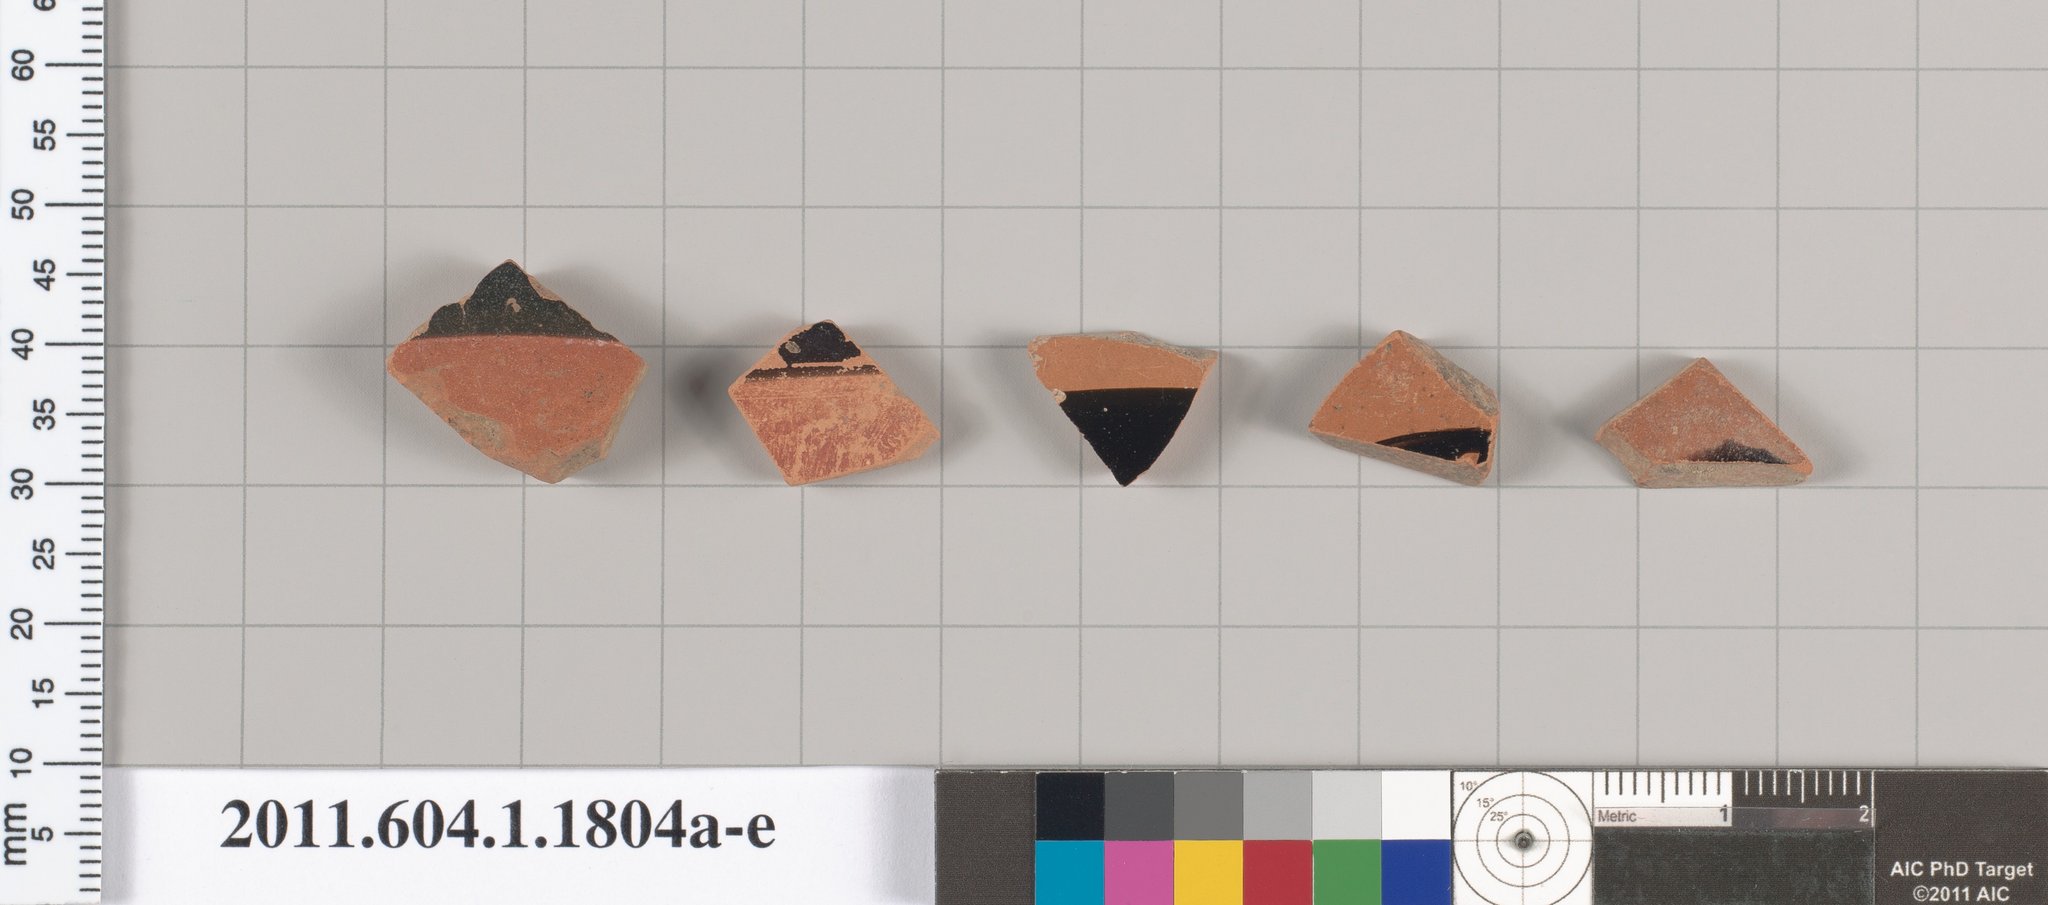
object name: kylix fragment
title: Terracotta rim fragments of kylikes(drinking cups)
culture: greek, attic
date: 500-401 BCE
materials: terracotta